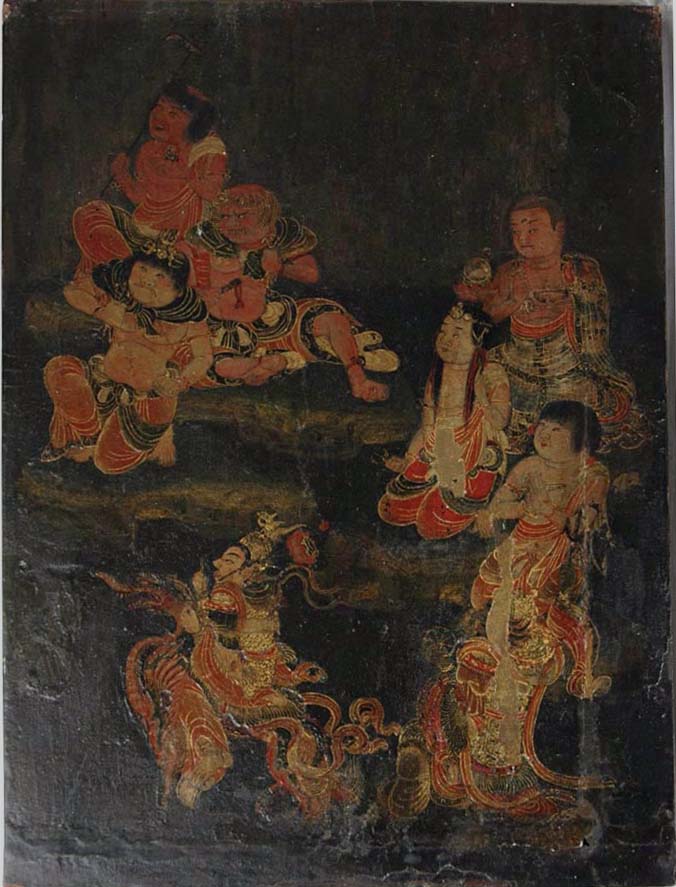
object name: door panel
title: Eight Attendants of Fudō Myōō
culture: japanese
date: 1401-1500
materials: gold, ink, wood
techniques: lacquer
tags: men,buddhism